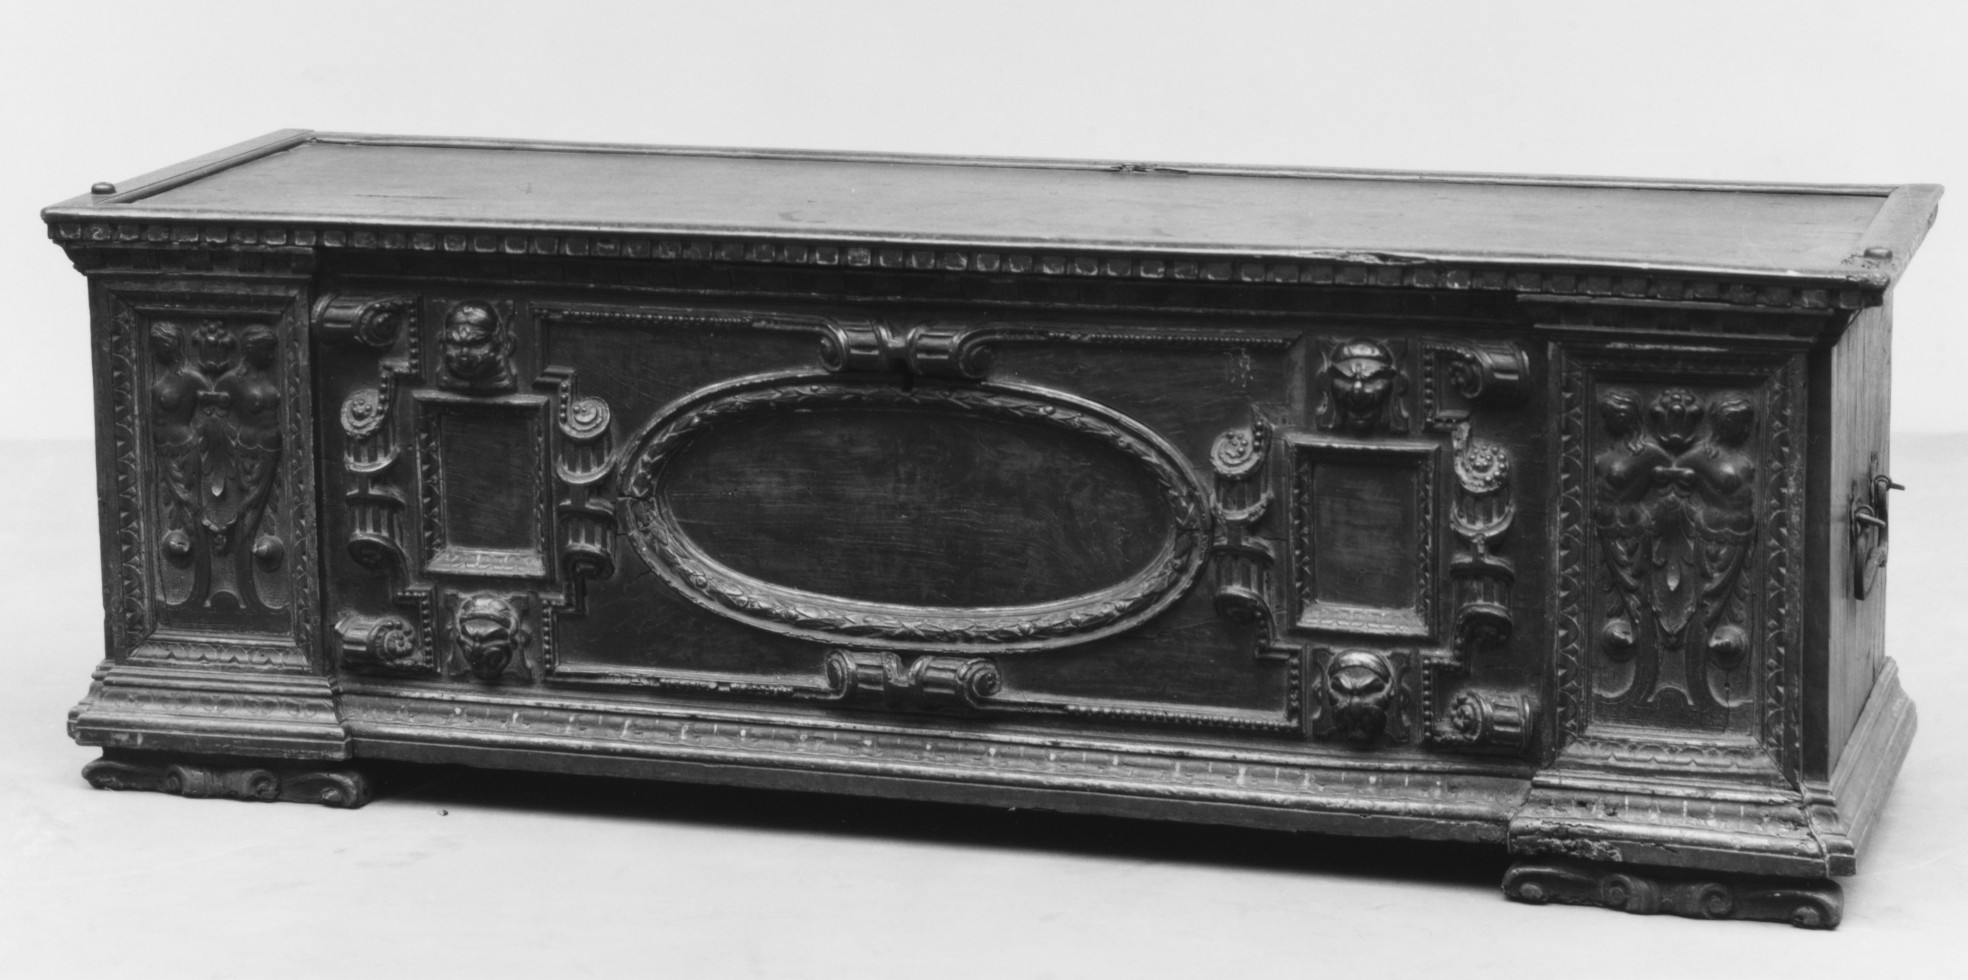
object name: cassone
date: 1551-1600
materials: wood